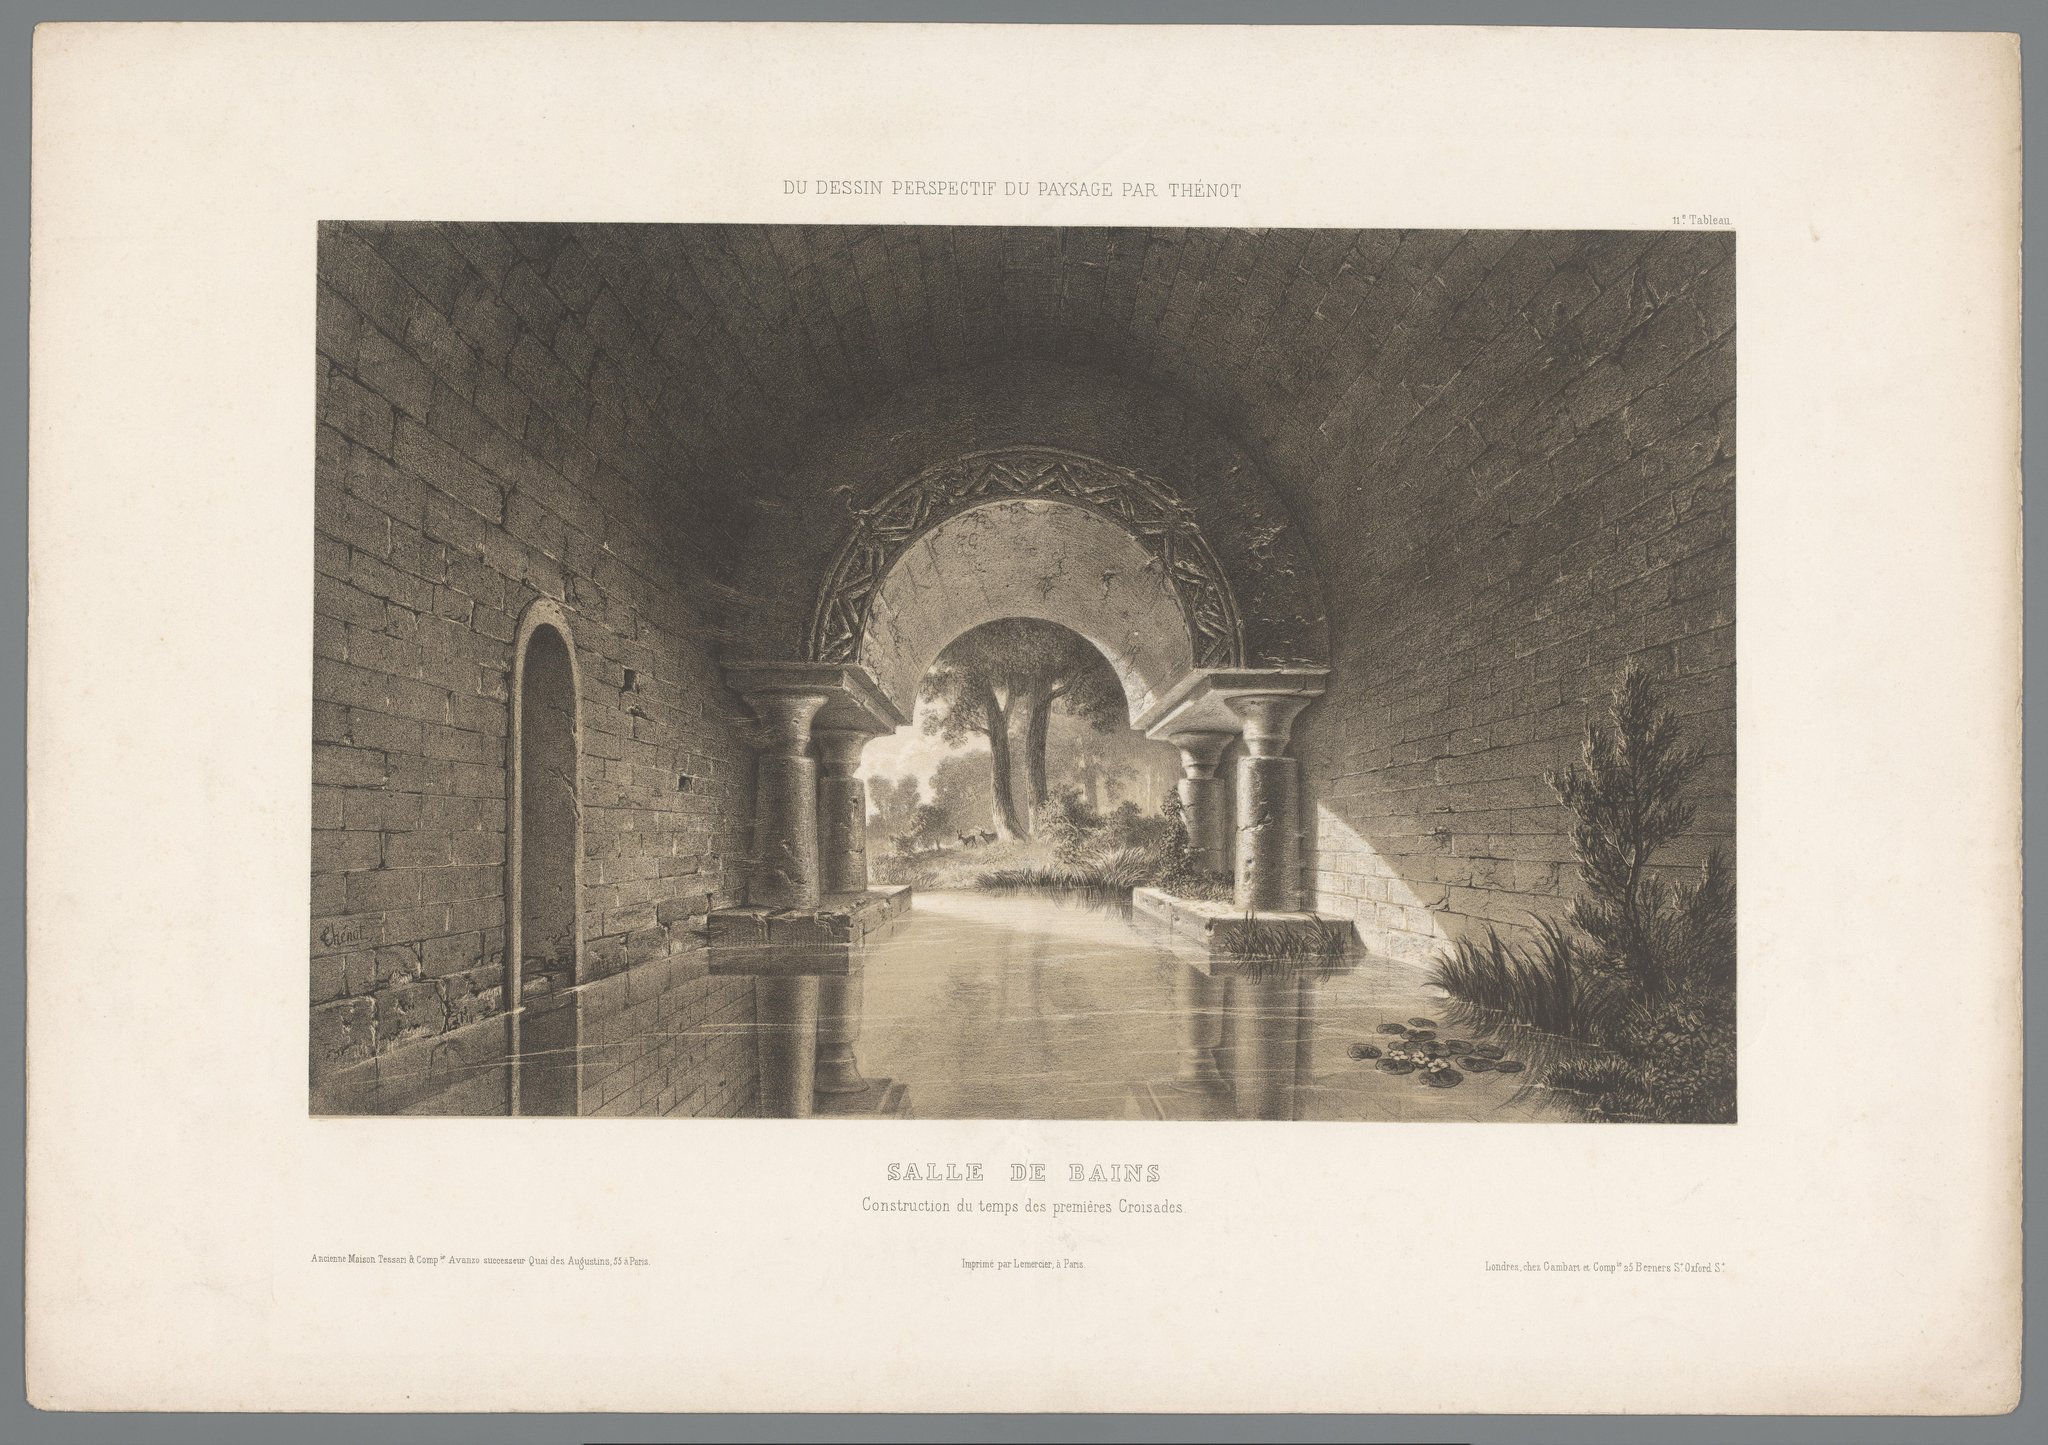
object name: print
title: Doorkijk over overwelfde vijver naar een bos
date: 1840-1870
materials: paper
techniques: tone lithography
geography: paris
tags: landscapes - hh - ideal landscapes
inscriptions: collector's mark: Lugt 2228